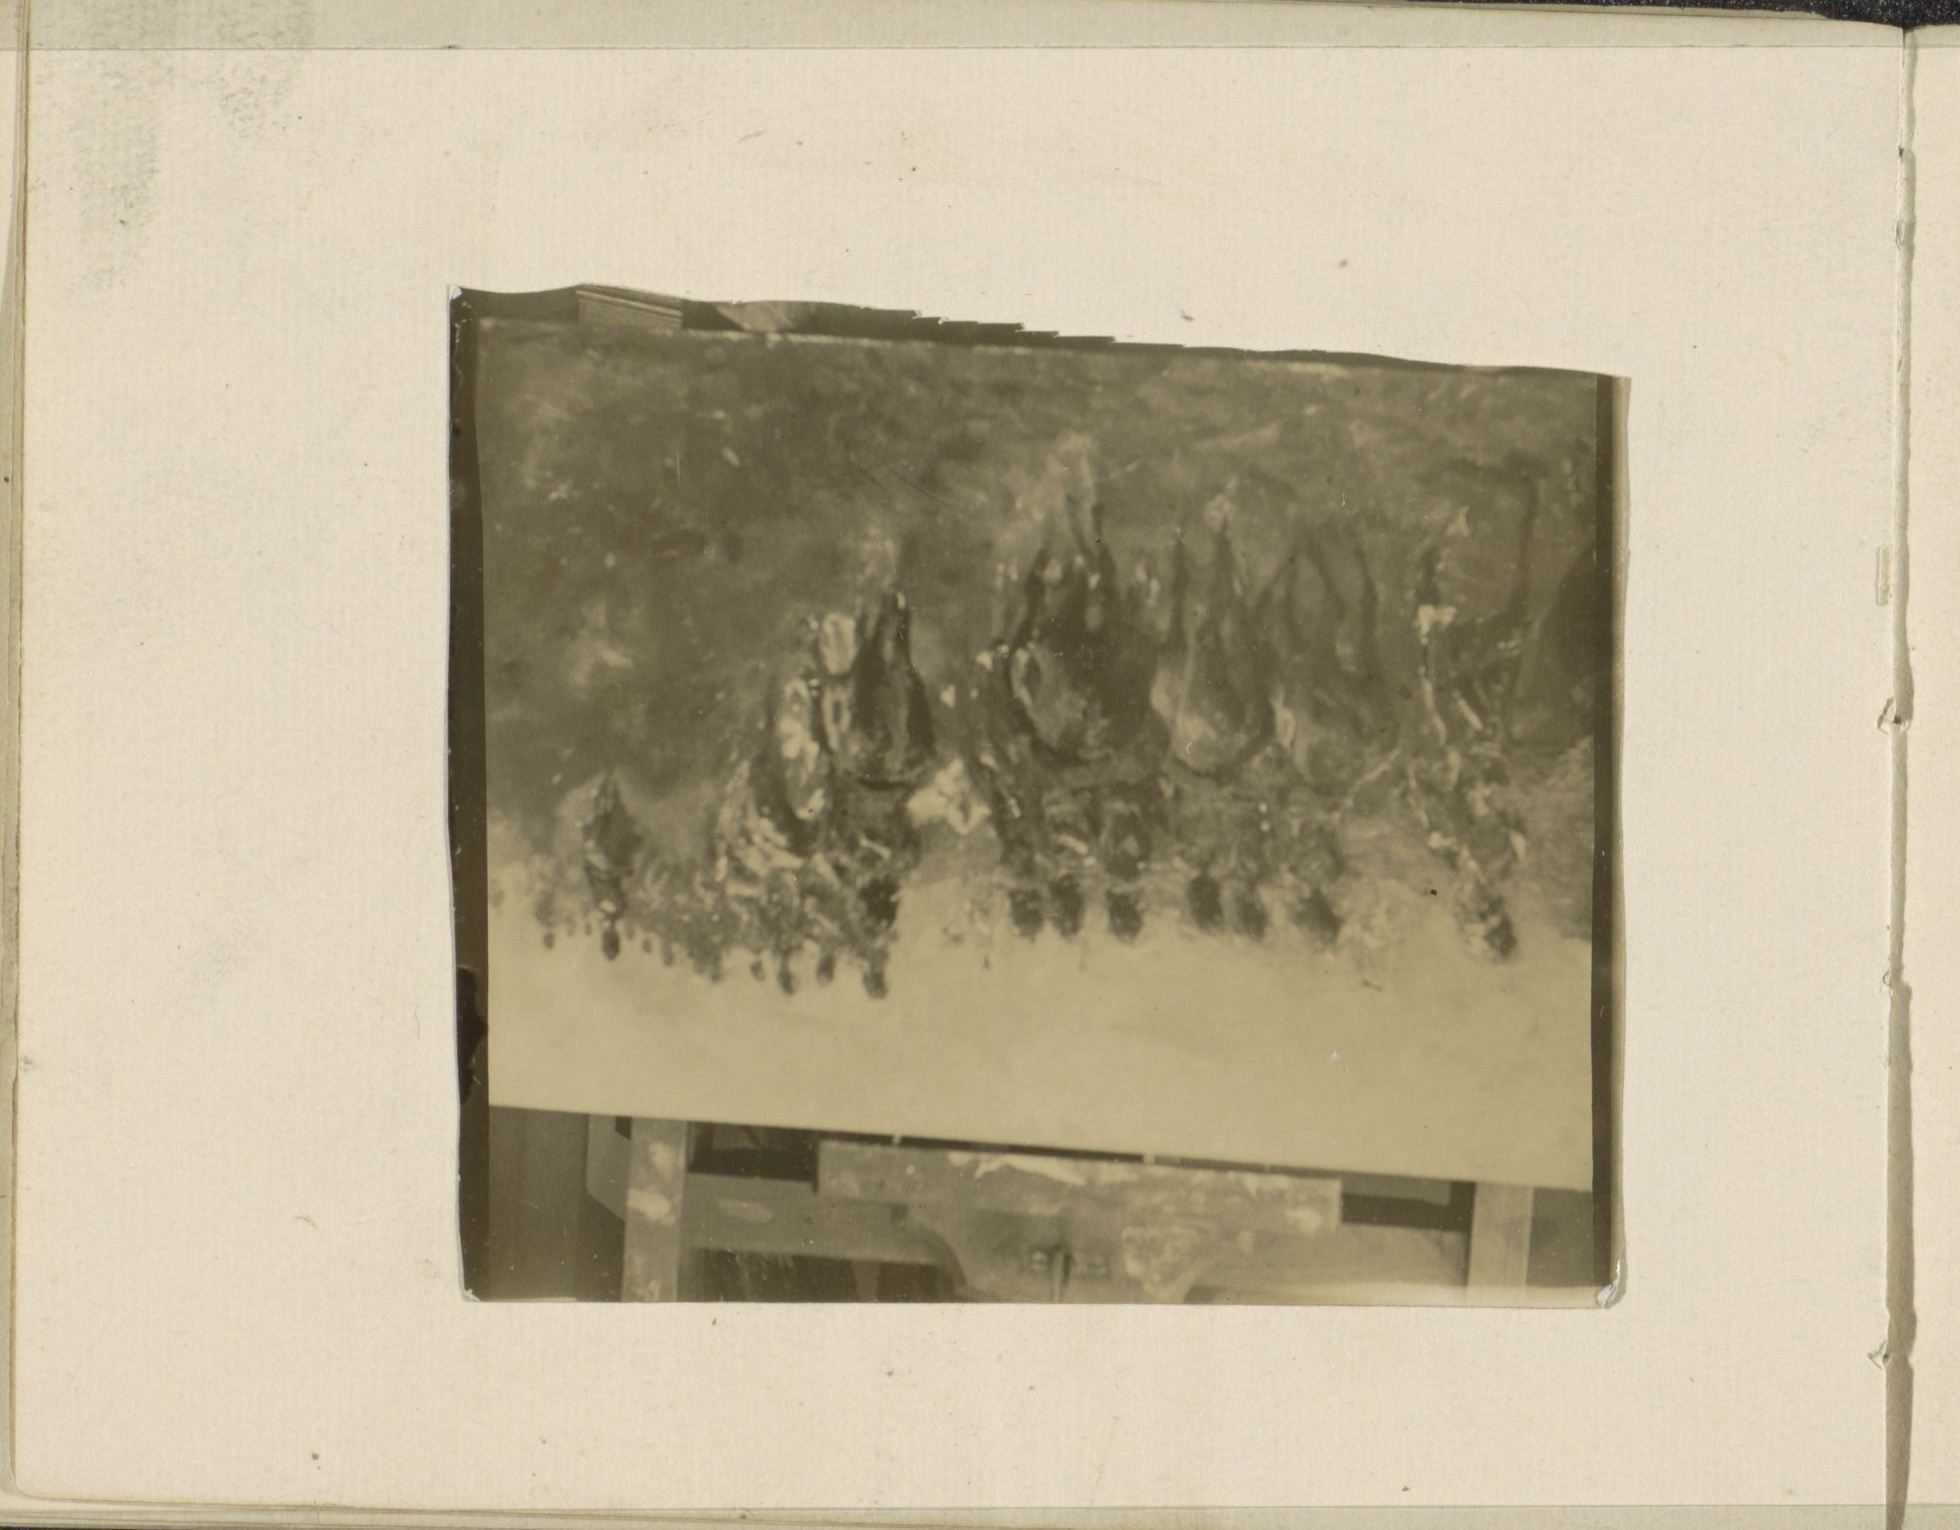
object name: sketchbook leaf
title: Schilderij op een ezel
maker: george hendrik breitner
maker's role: draughtsman, painter, print maker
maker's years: 1857-1923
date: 1885-1898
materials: paper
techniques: gelatin silver print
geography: amsterdam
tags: the soldier; the soldier's life (+ cavalry, horsemen)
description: Het schilderij is zeer waarschijnlijk Breitners 'Cavalerie op de heide' uit de collectie van het Stedelijk Museum, Amsterdam.